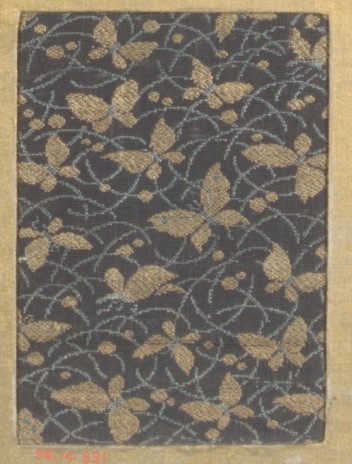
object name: piece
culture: japanese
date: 1701-1900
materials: silk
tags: butterflies